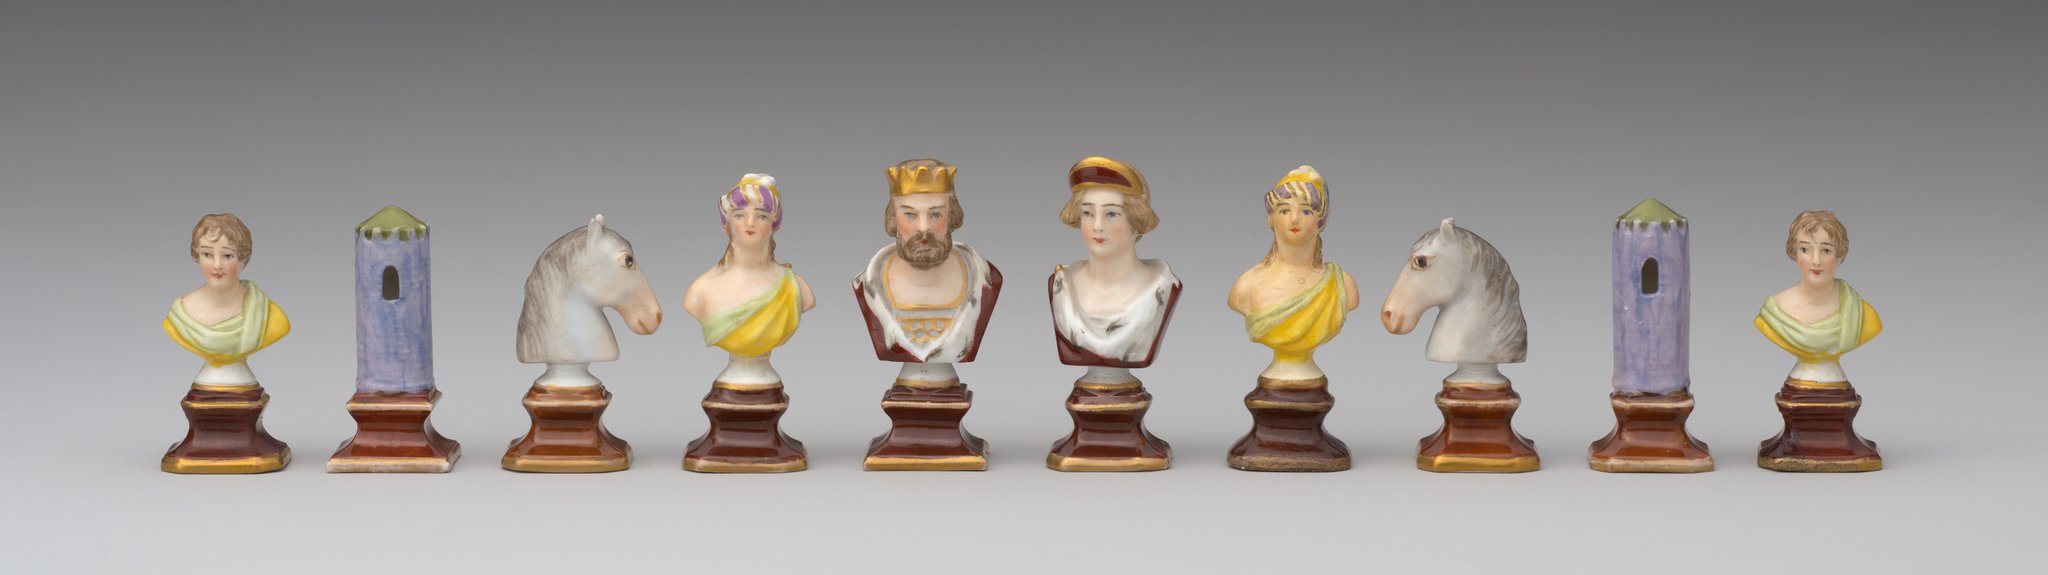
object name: chessman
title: "Battle of blondes and brunettes" chessmen (32)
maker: royal porcelain manufactory, berlin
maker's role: manufactory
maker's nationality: german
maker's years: 1763-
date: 1870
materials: hard paste porcelain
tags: chess,games